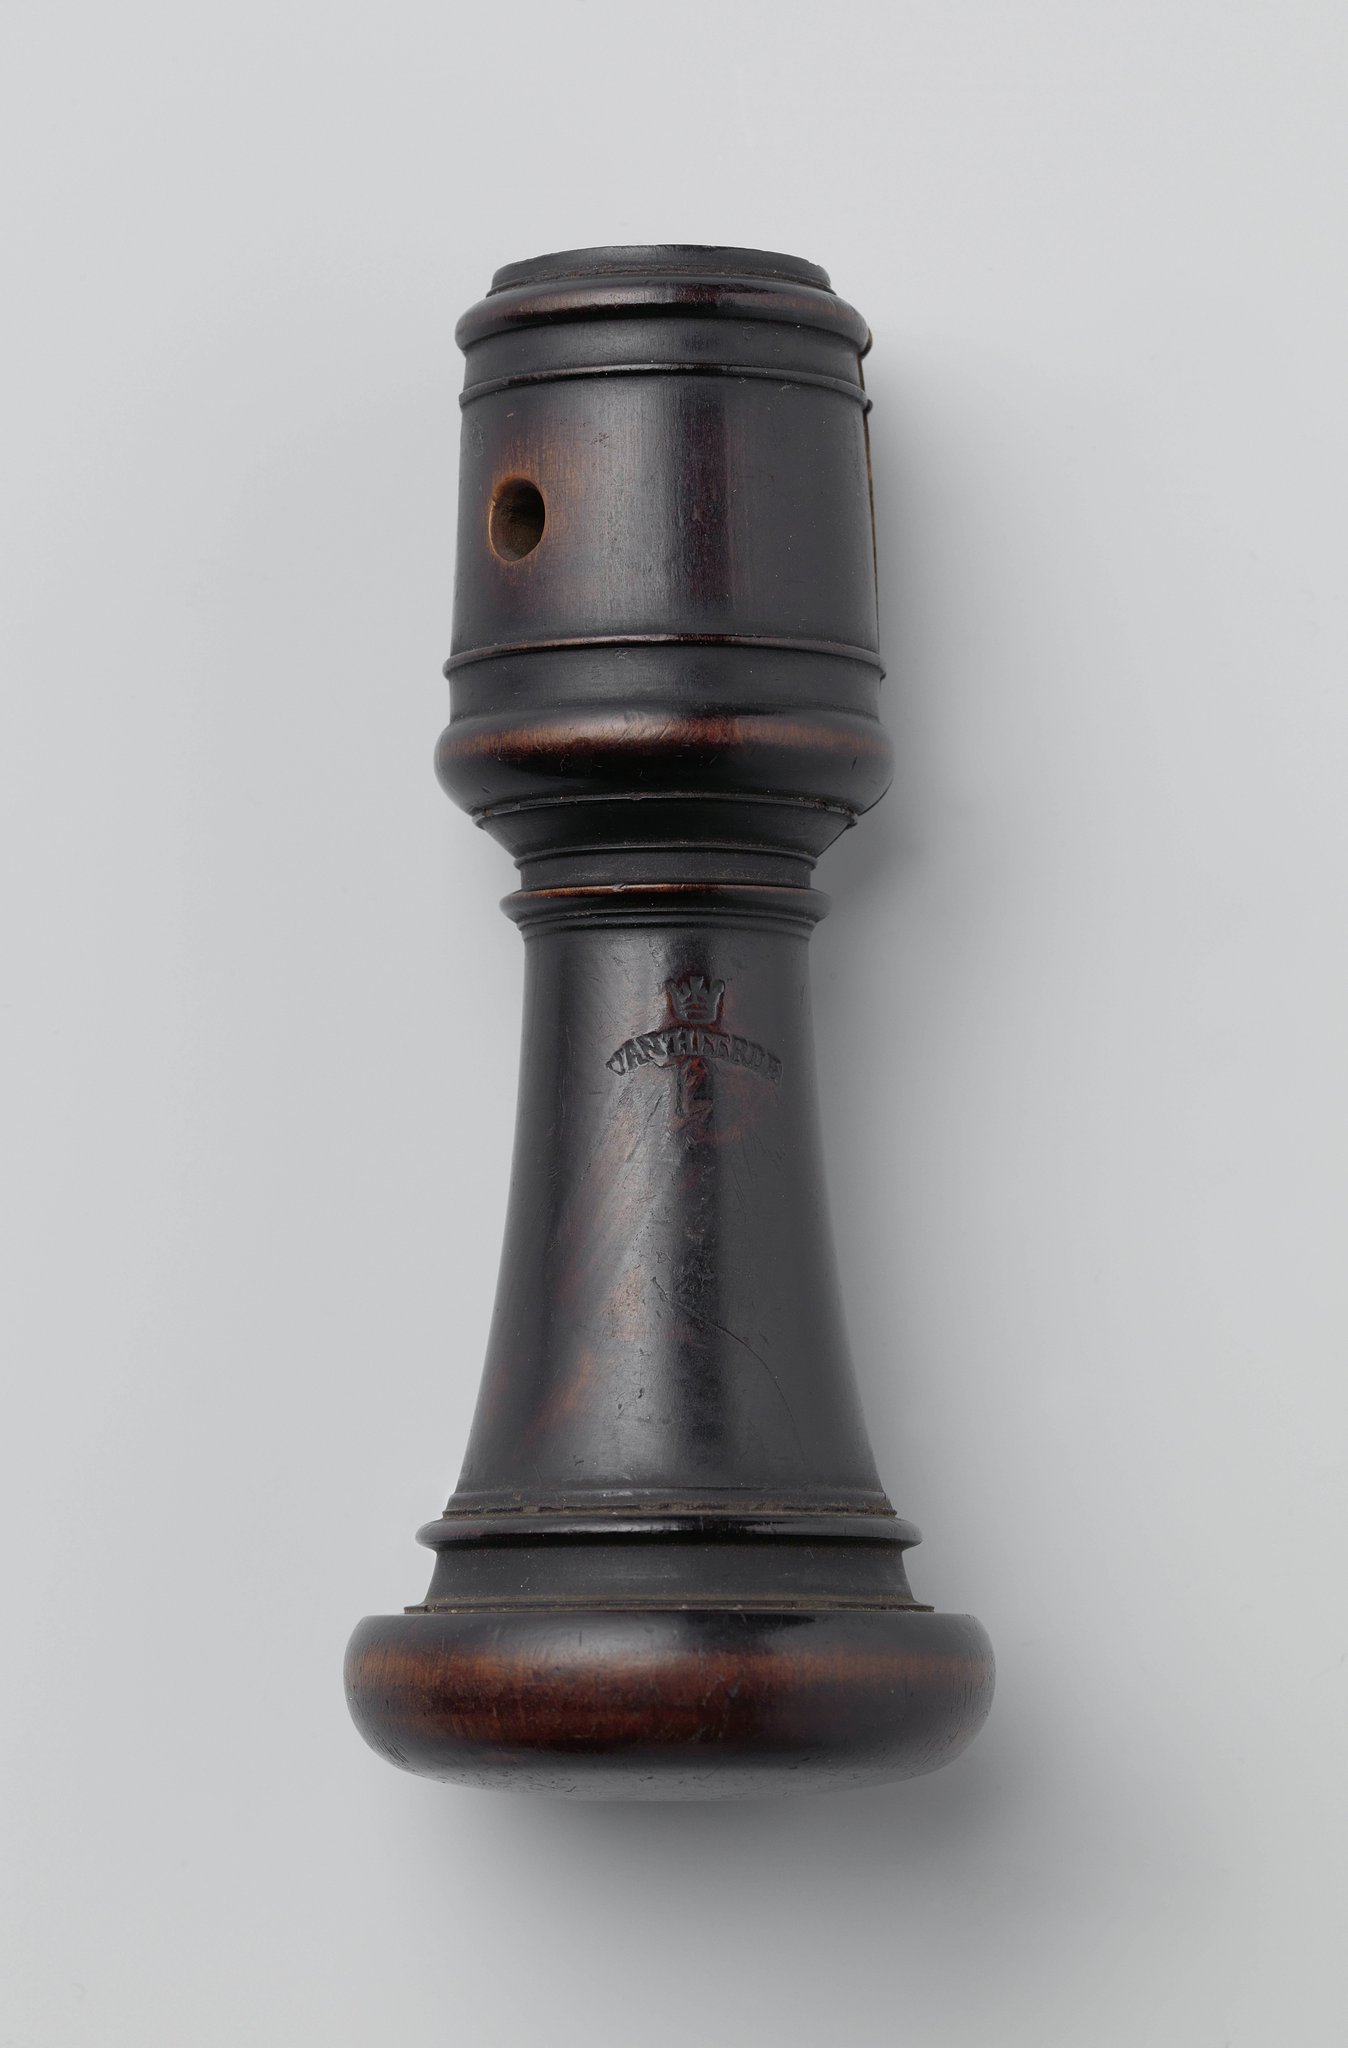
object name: flute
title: Alto recorder (foot)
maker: thomas coenrat boekhout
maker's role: musical instrument maker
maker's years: 1666-1715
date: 1700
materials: wood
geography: amsterdam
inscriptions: signature: ‘VAN HEERDE’